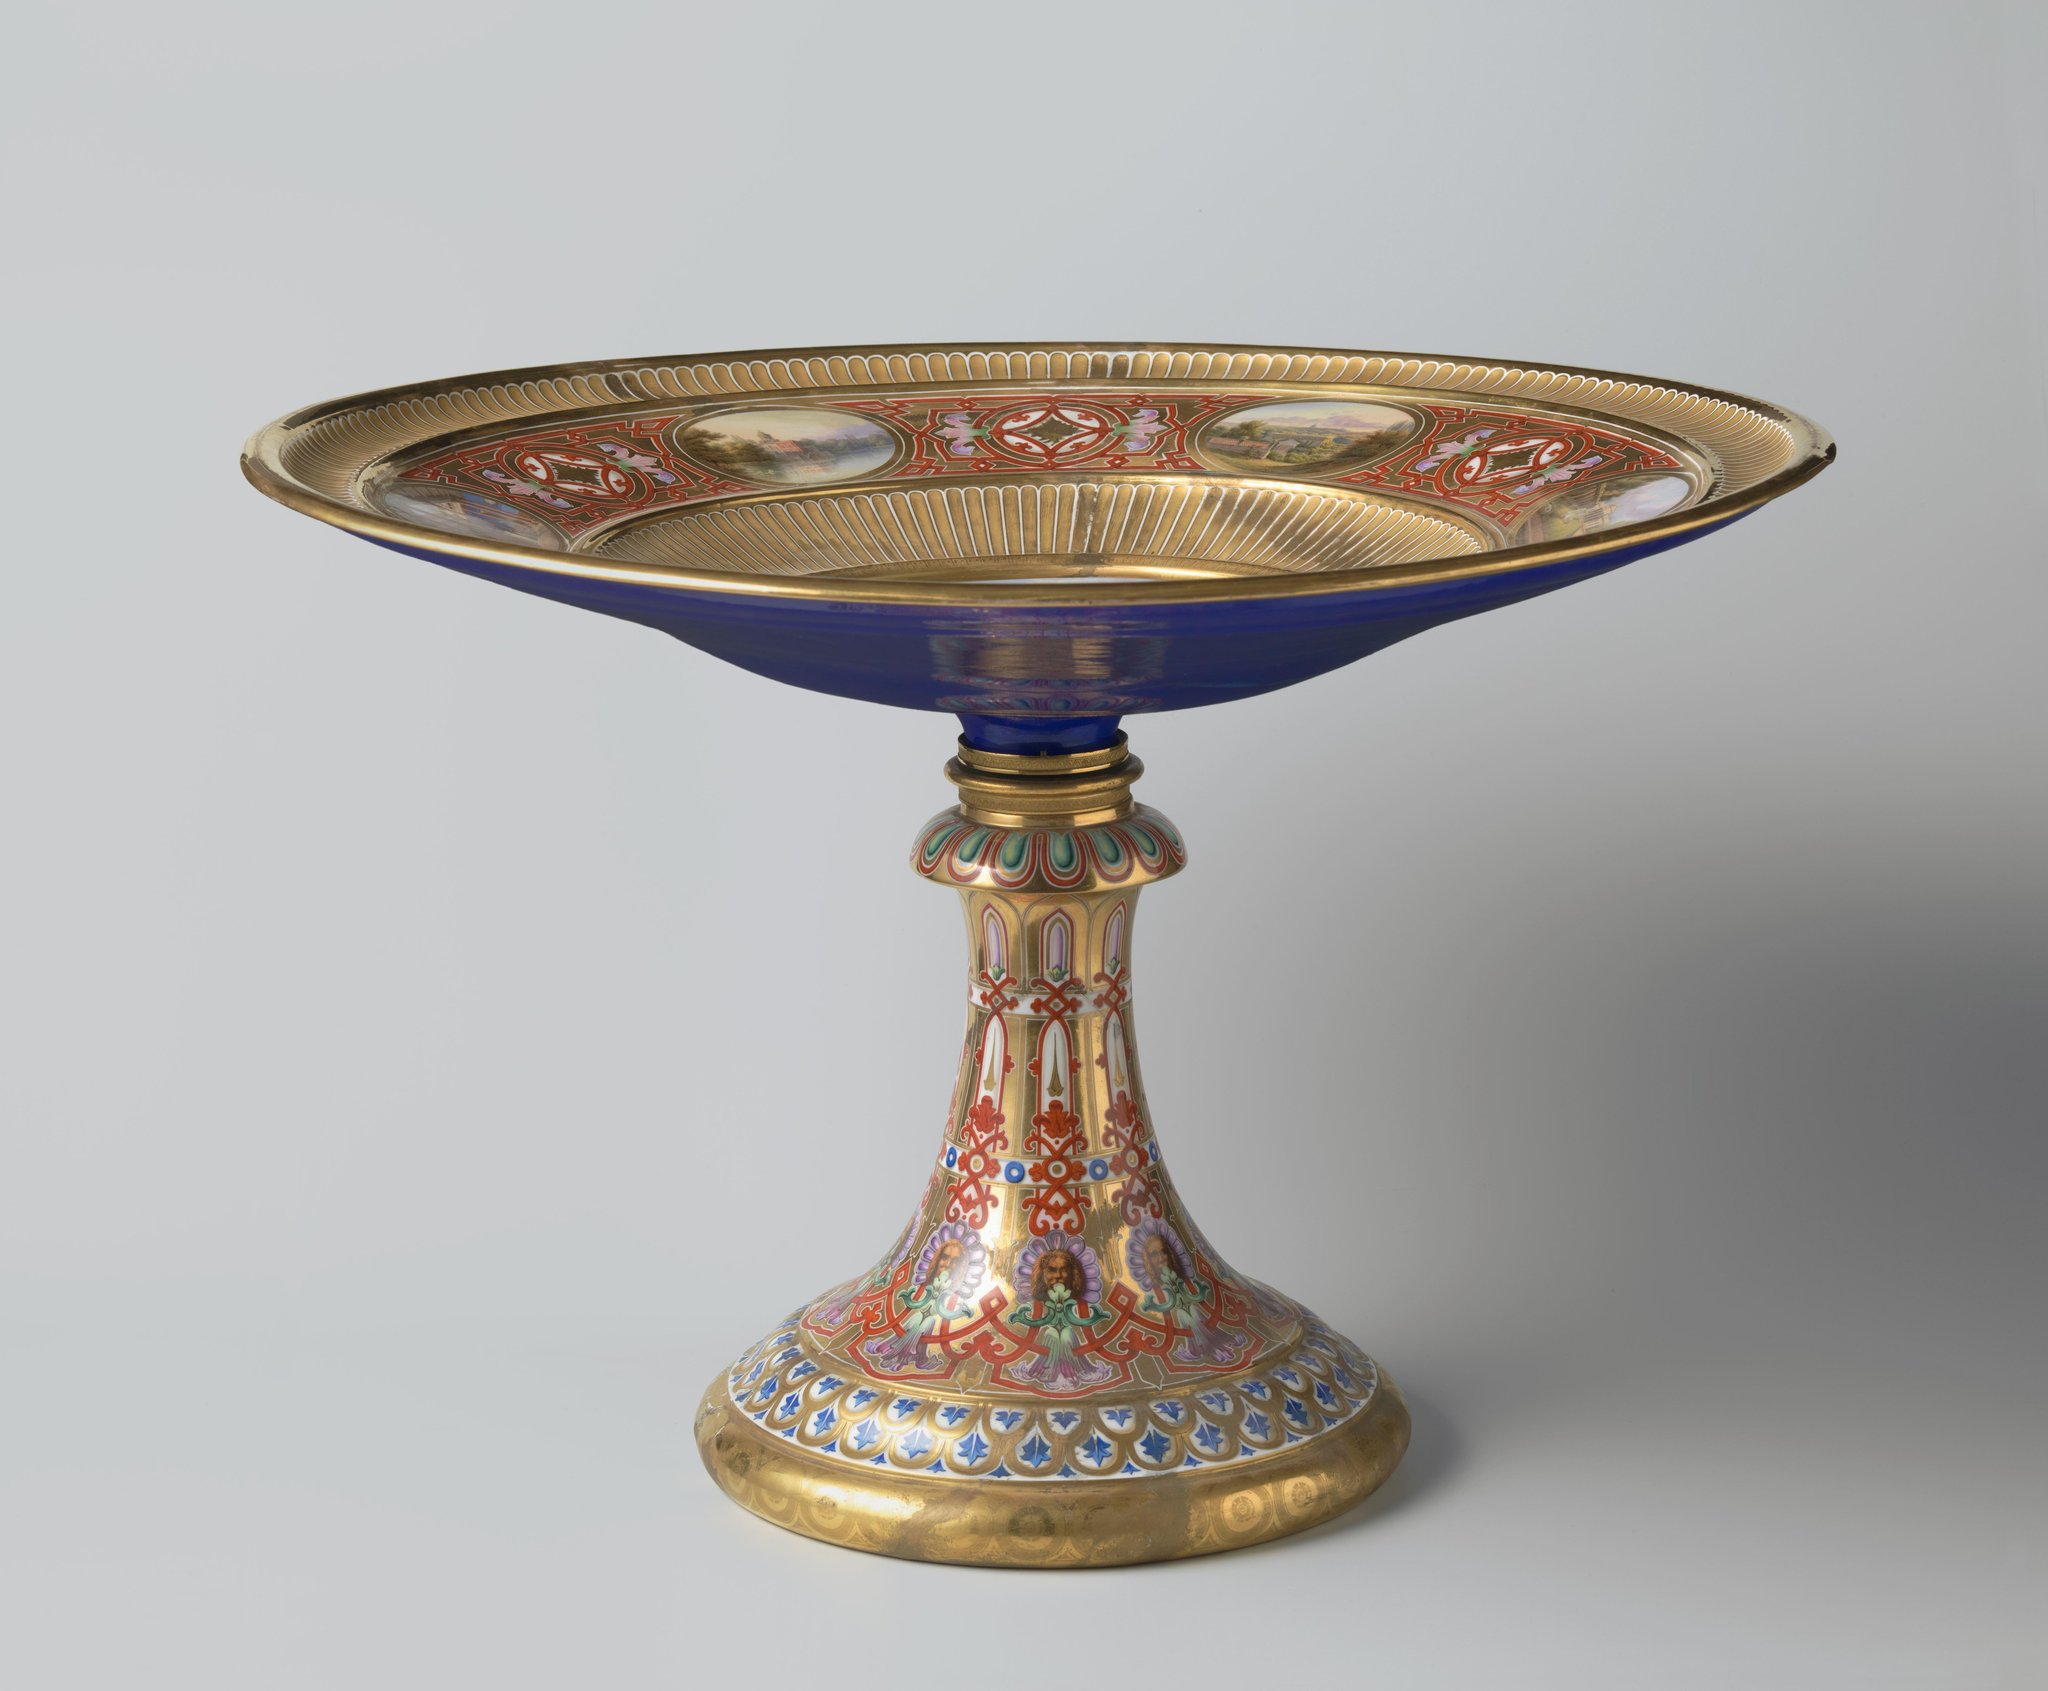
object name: dish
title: Dish with landscapes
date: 1837-1844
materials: glaze, gold, paint, porcelain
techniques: firing, forming, vitrification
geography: berlin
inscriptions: mark: ‘scepter waaronder K.P.M.’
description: Schaal van een coupe of drinkschaal van porselein met een koperen montuur met ijzeren pin om in de hoge voet te plaatsen. Beschilderd met emailkleuren en goud. Op het plat een landschap met een prominent gebouw. Op de rand een decoratieve band met medaillons en bloemen, waartussen zesmaal een ovaal vak met een klein landschap, telkens ook met een prominent gebouw. De buitenzijde van de schaal is blauw. De binnenzijde is met beige overschilderd. Gemerkt aan de binnenzijde van de voet met de scepter waaronder K.P.M.